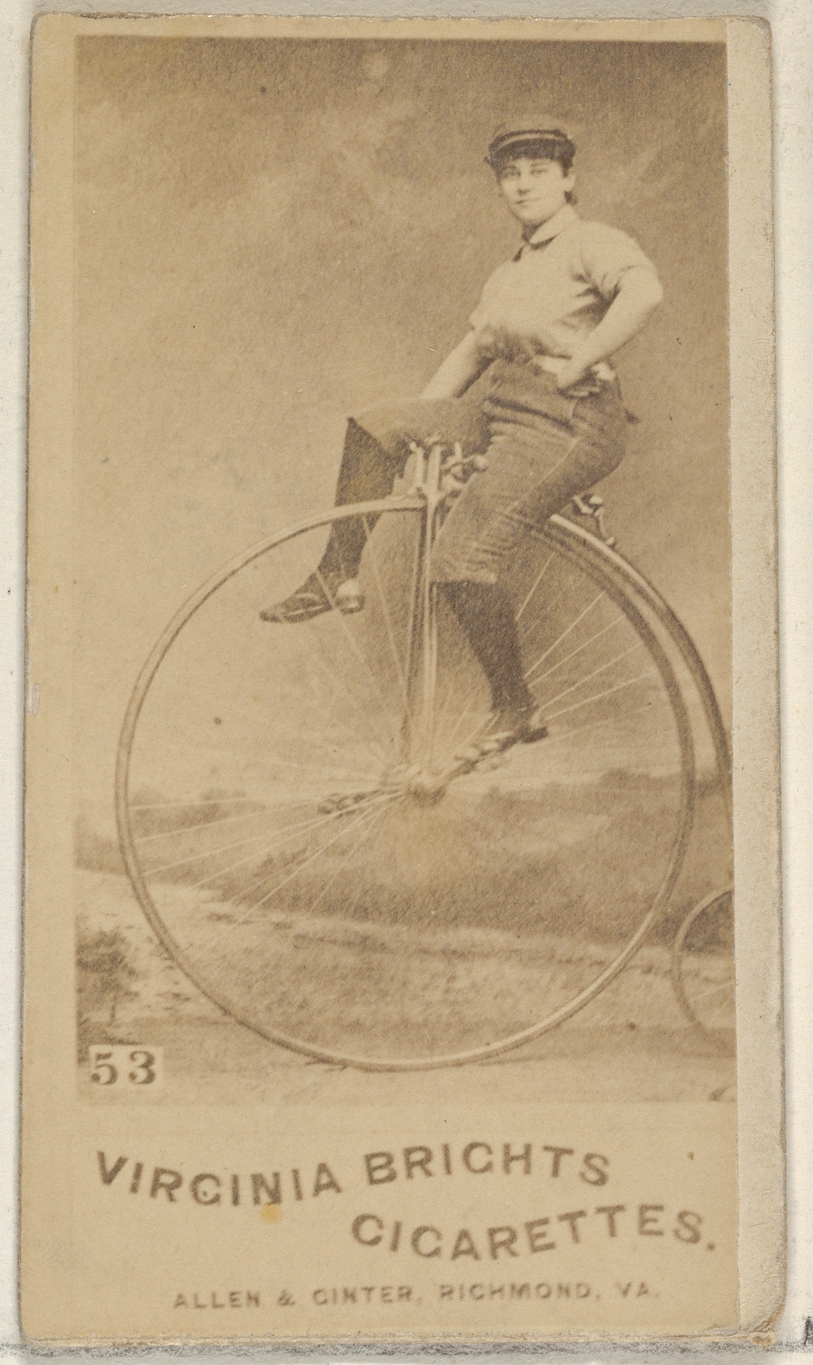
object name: photograph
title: Card 53, from the Girl Cyclists series (N49) for Virginia Brights Cigarettes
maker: allen & ginter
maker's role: publisher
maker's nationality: american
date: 1887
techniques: albumen silver print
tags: portraits,women,bicycles